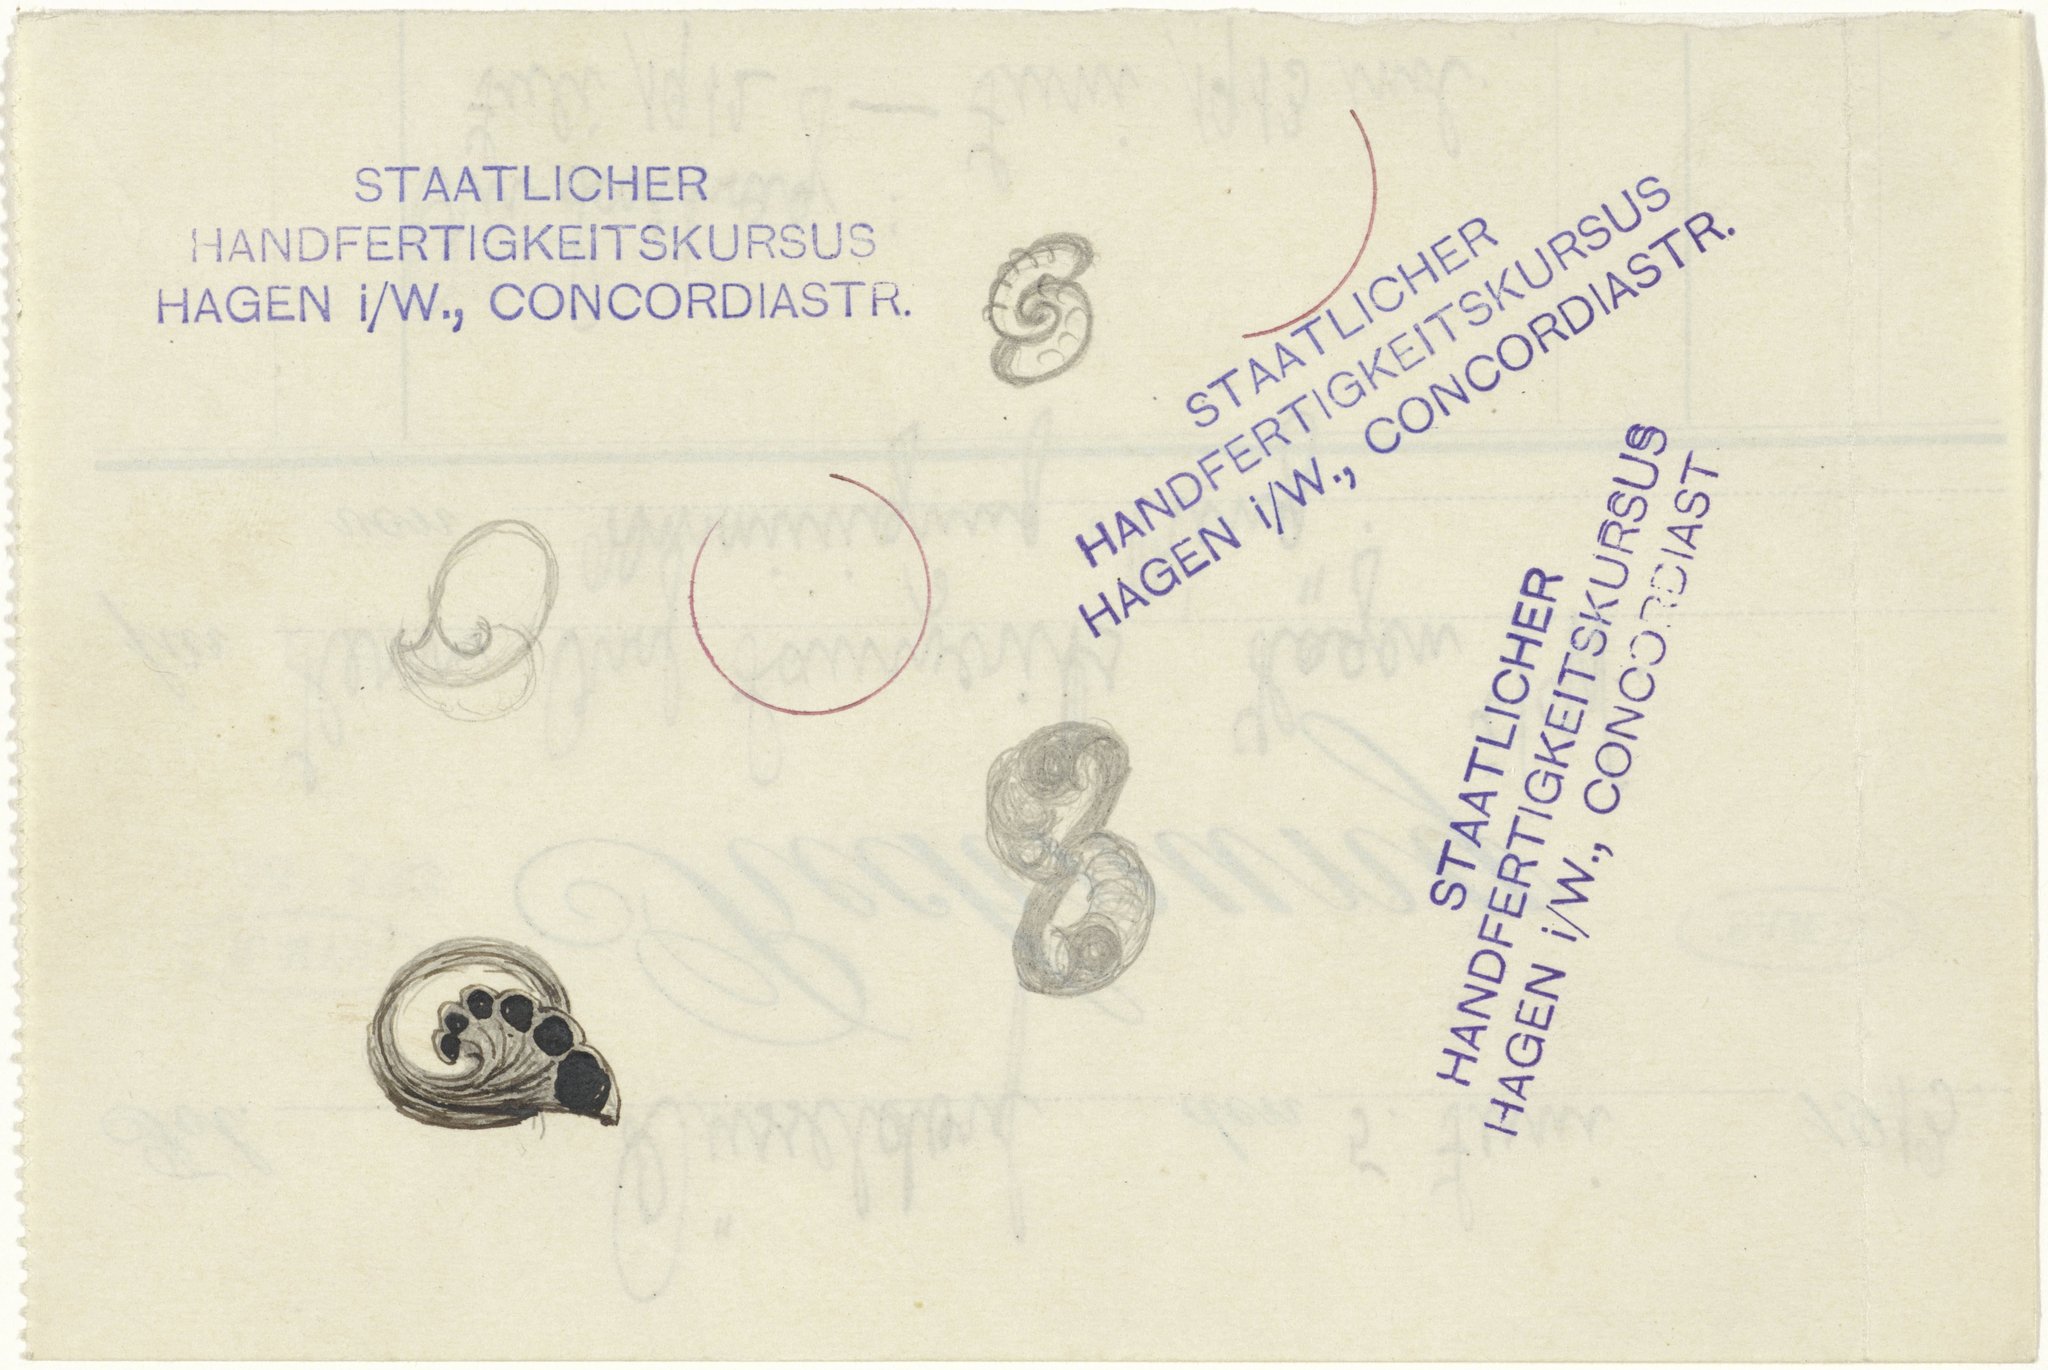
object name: design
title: Ontwerpen voor een ring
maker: mathieu lauweriks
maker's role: designer, draughtsman, print maker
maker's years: 1864-1932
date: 1913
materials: ink, paper, pencil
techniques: pen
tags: ring